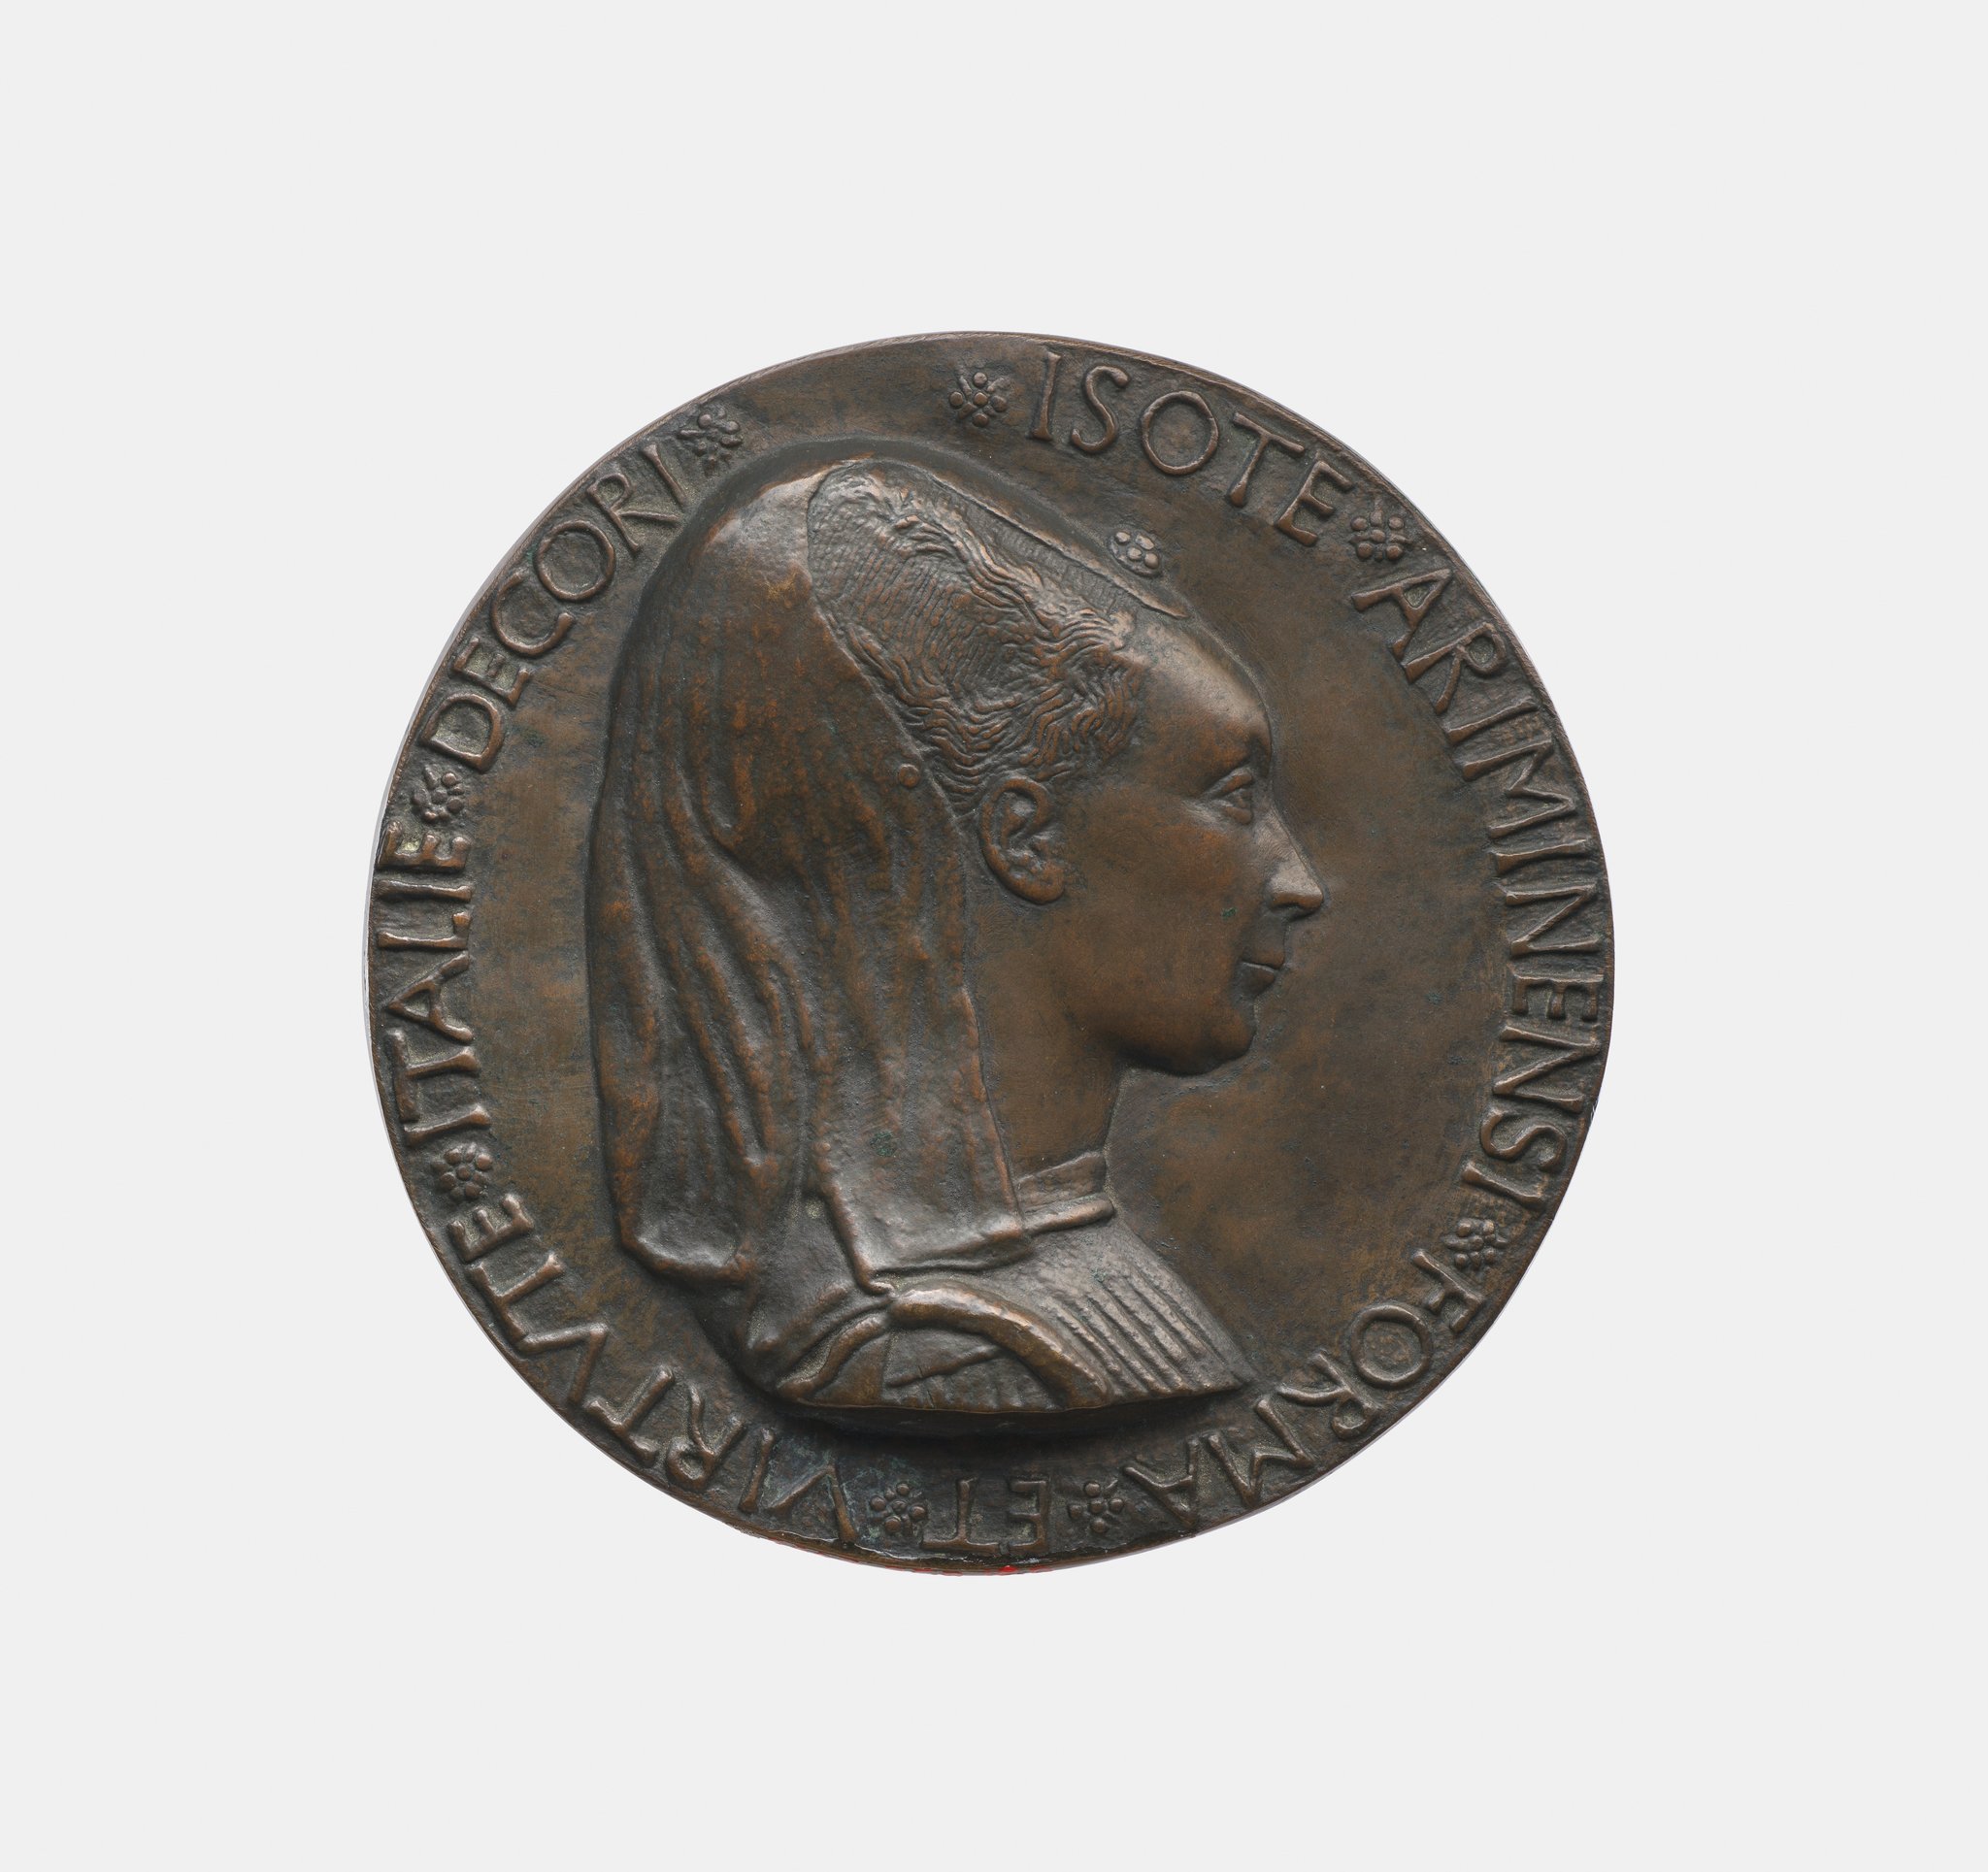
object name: medal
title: Isotta degli Atti (1432/3–1474)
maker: matteo de' pasti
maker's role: artist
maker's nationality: italian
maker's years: 1420-1467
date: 1449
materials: bronze